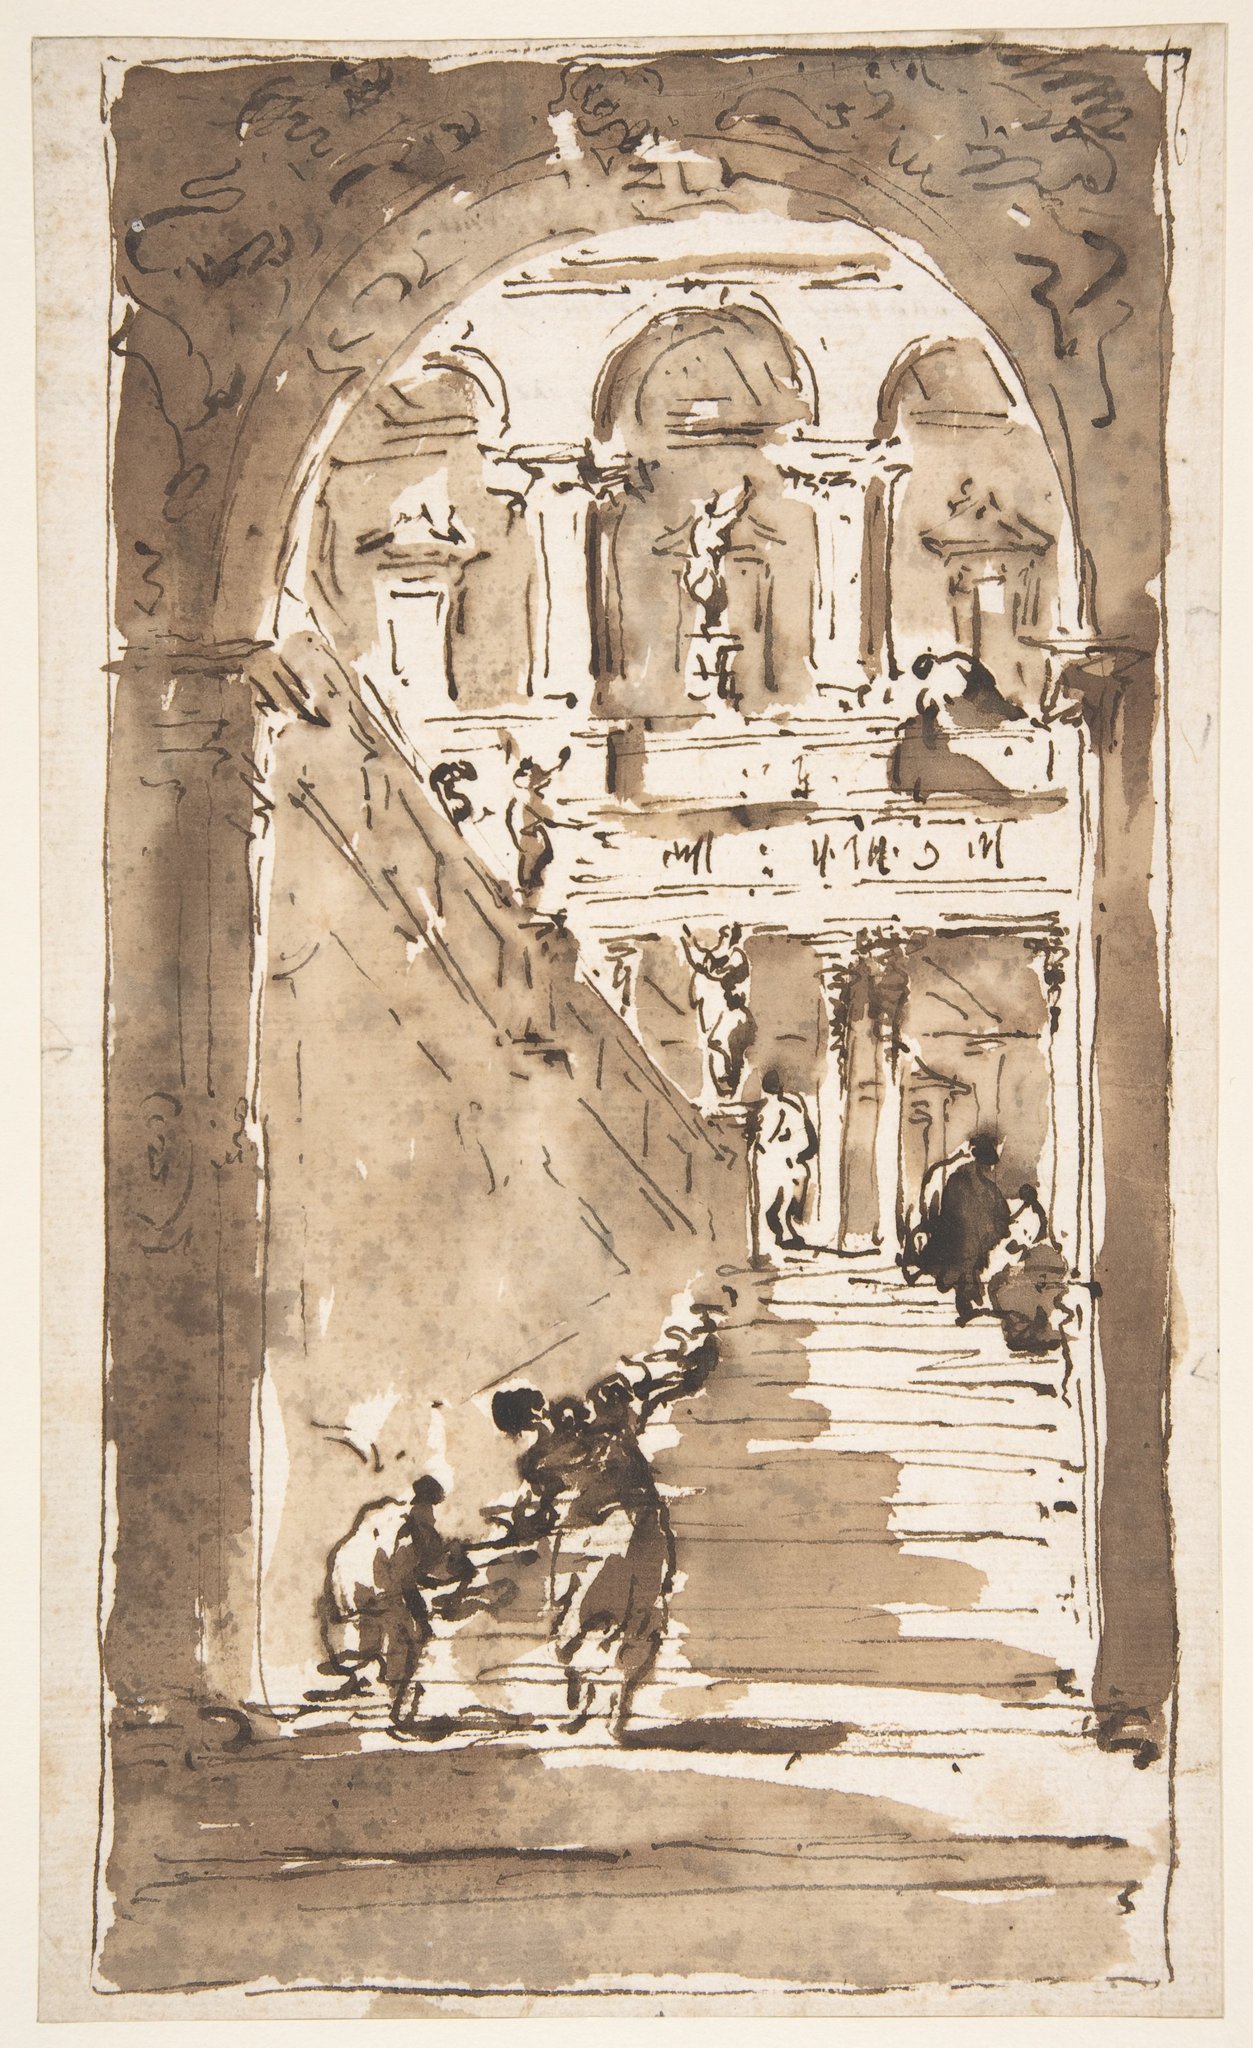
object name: drawing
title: Architectural Fantasy: Figures on a Grand Staircase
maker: francesco guardi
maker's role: artist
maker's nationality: italian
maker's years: 1712-1793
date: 1712-1793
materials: ink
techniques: brush, pen, wash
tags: human figures,stairs